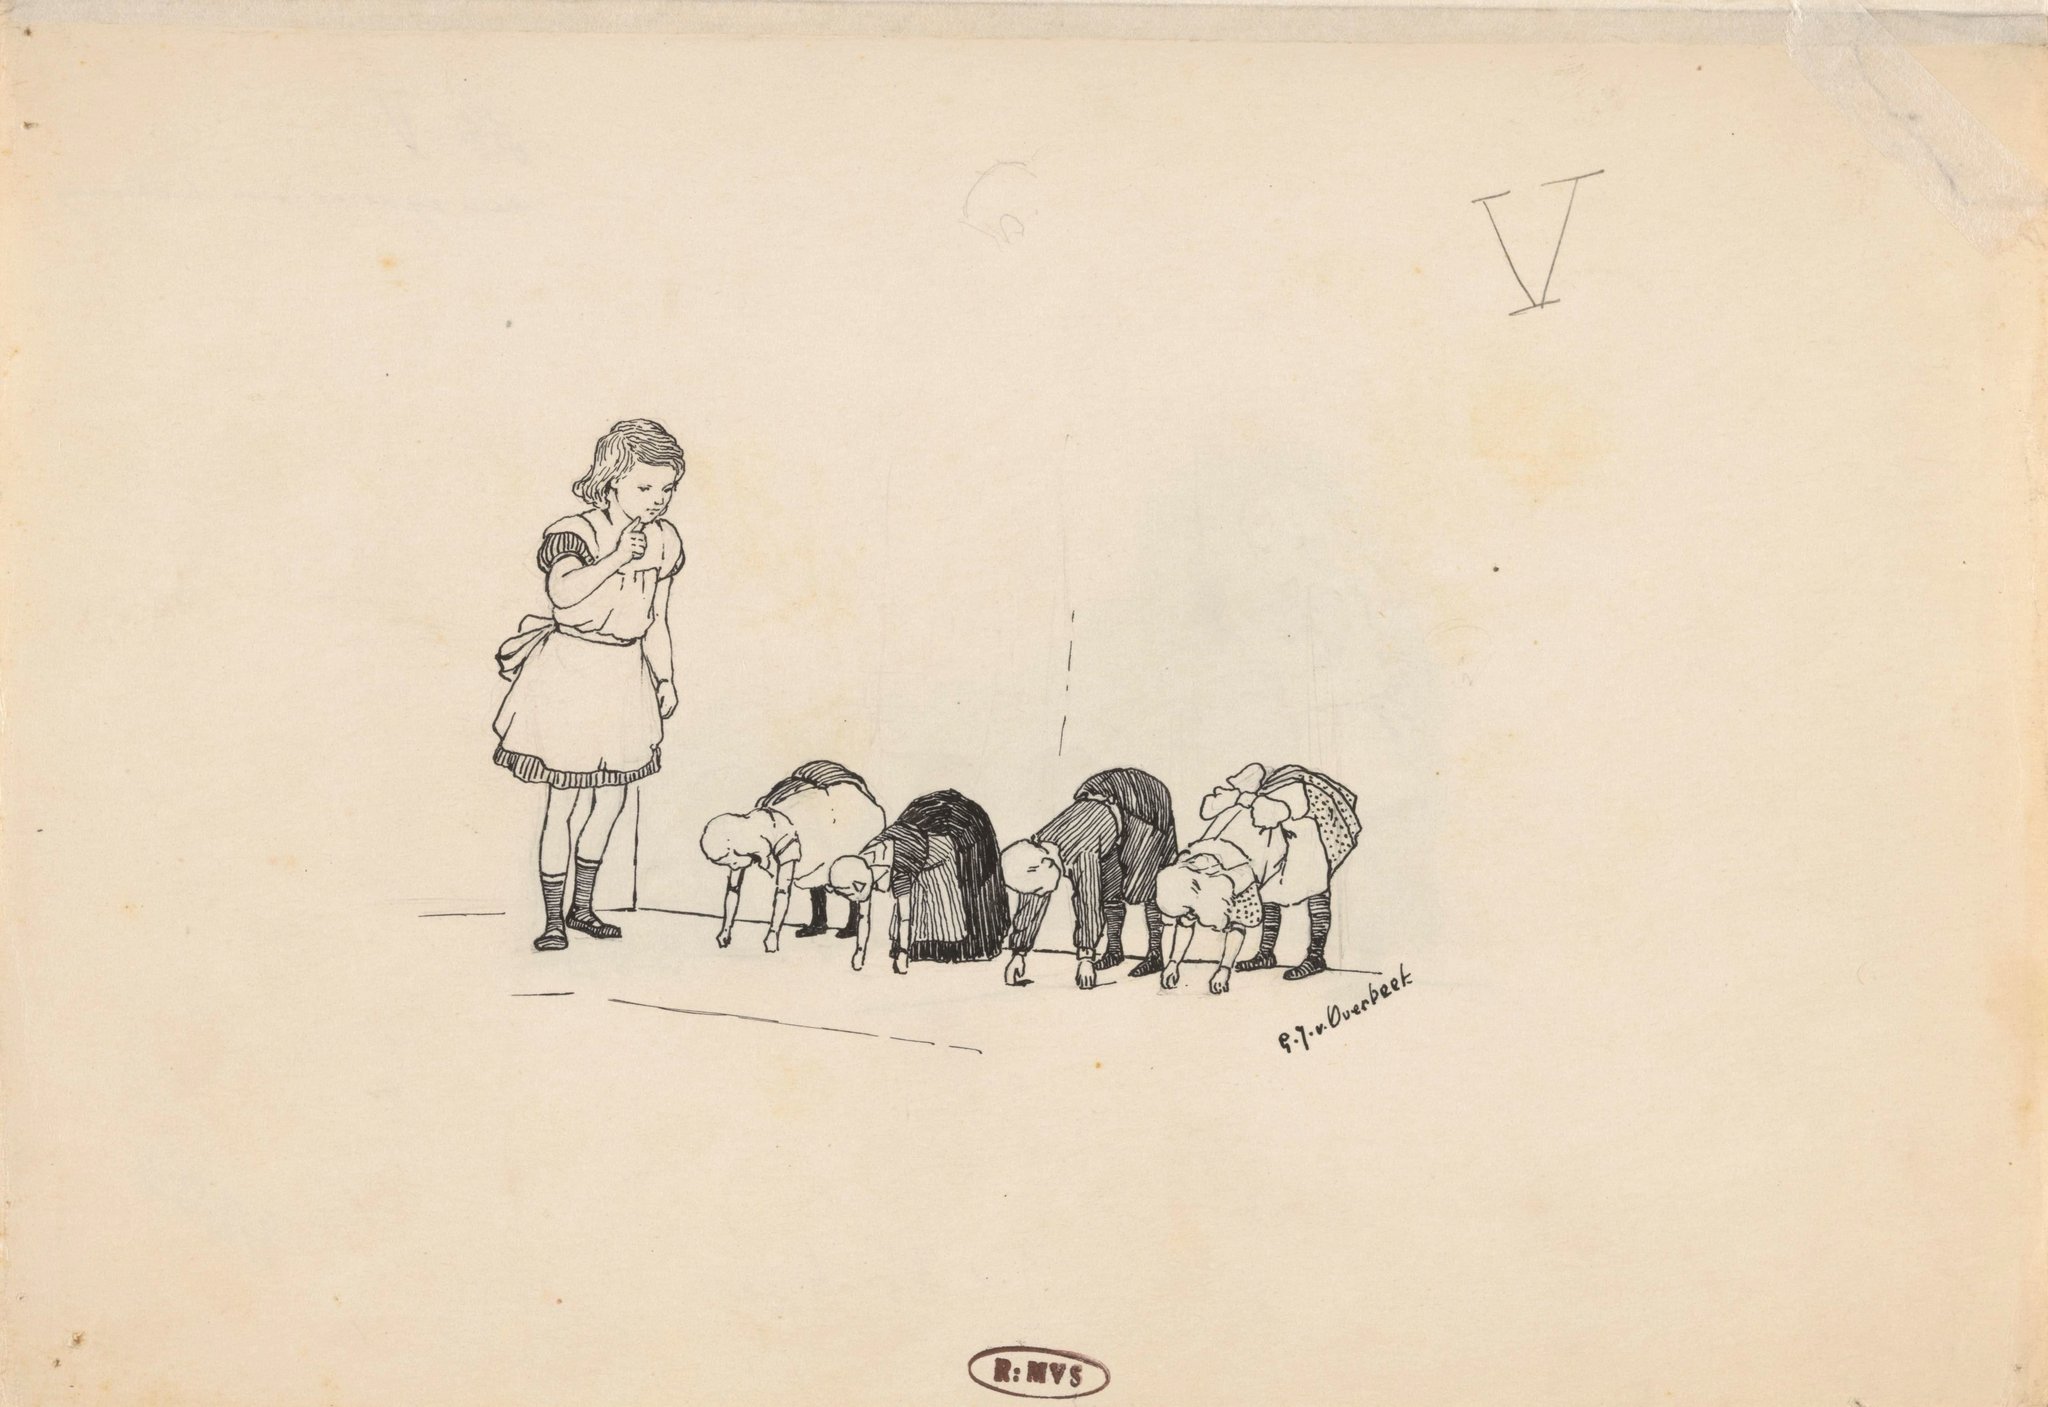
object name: drawing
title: Meisje straft haar poppen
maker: gijsbertus johannes van overbeek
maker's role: draughtsman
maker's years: 1882-1947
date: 1892-1947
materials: ink, paper, pencil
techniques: pen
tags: (playing with) dolls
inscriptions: collector's mark: Lugt 2228, number: ‘V’, signature: ‘G.J. v. Overbeek’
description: Een meisje heft haar rechter wijsvinger op naar haar vier poppen, die zij op een rij tegen de muur heeft opgesteld met de handen en het hoofd naar beneden.